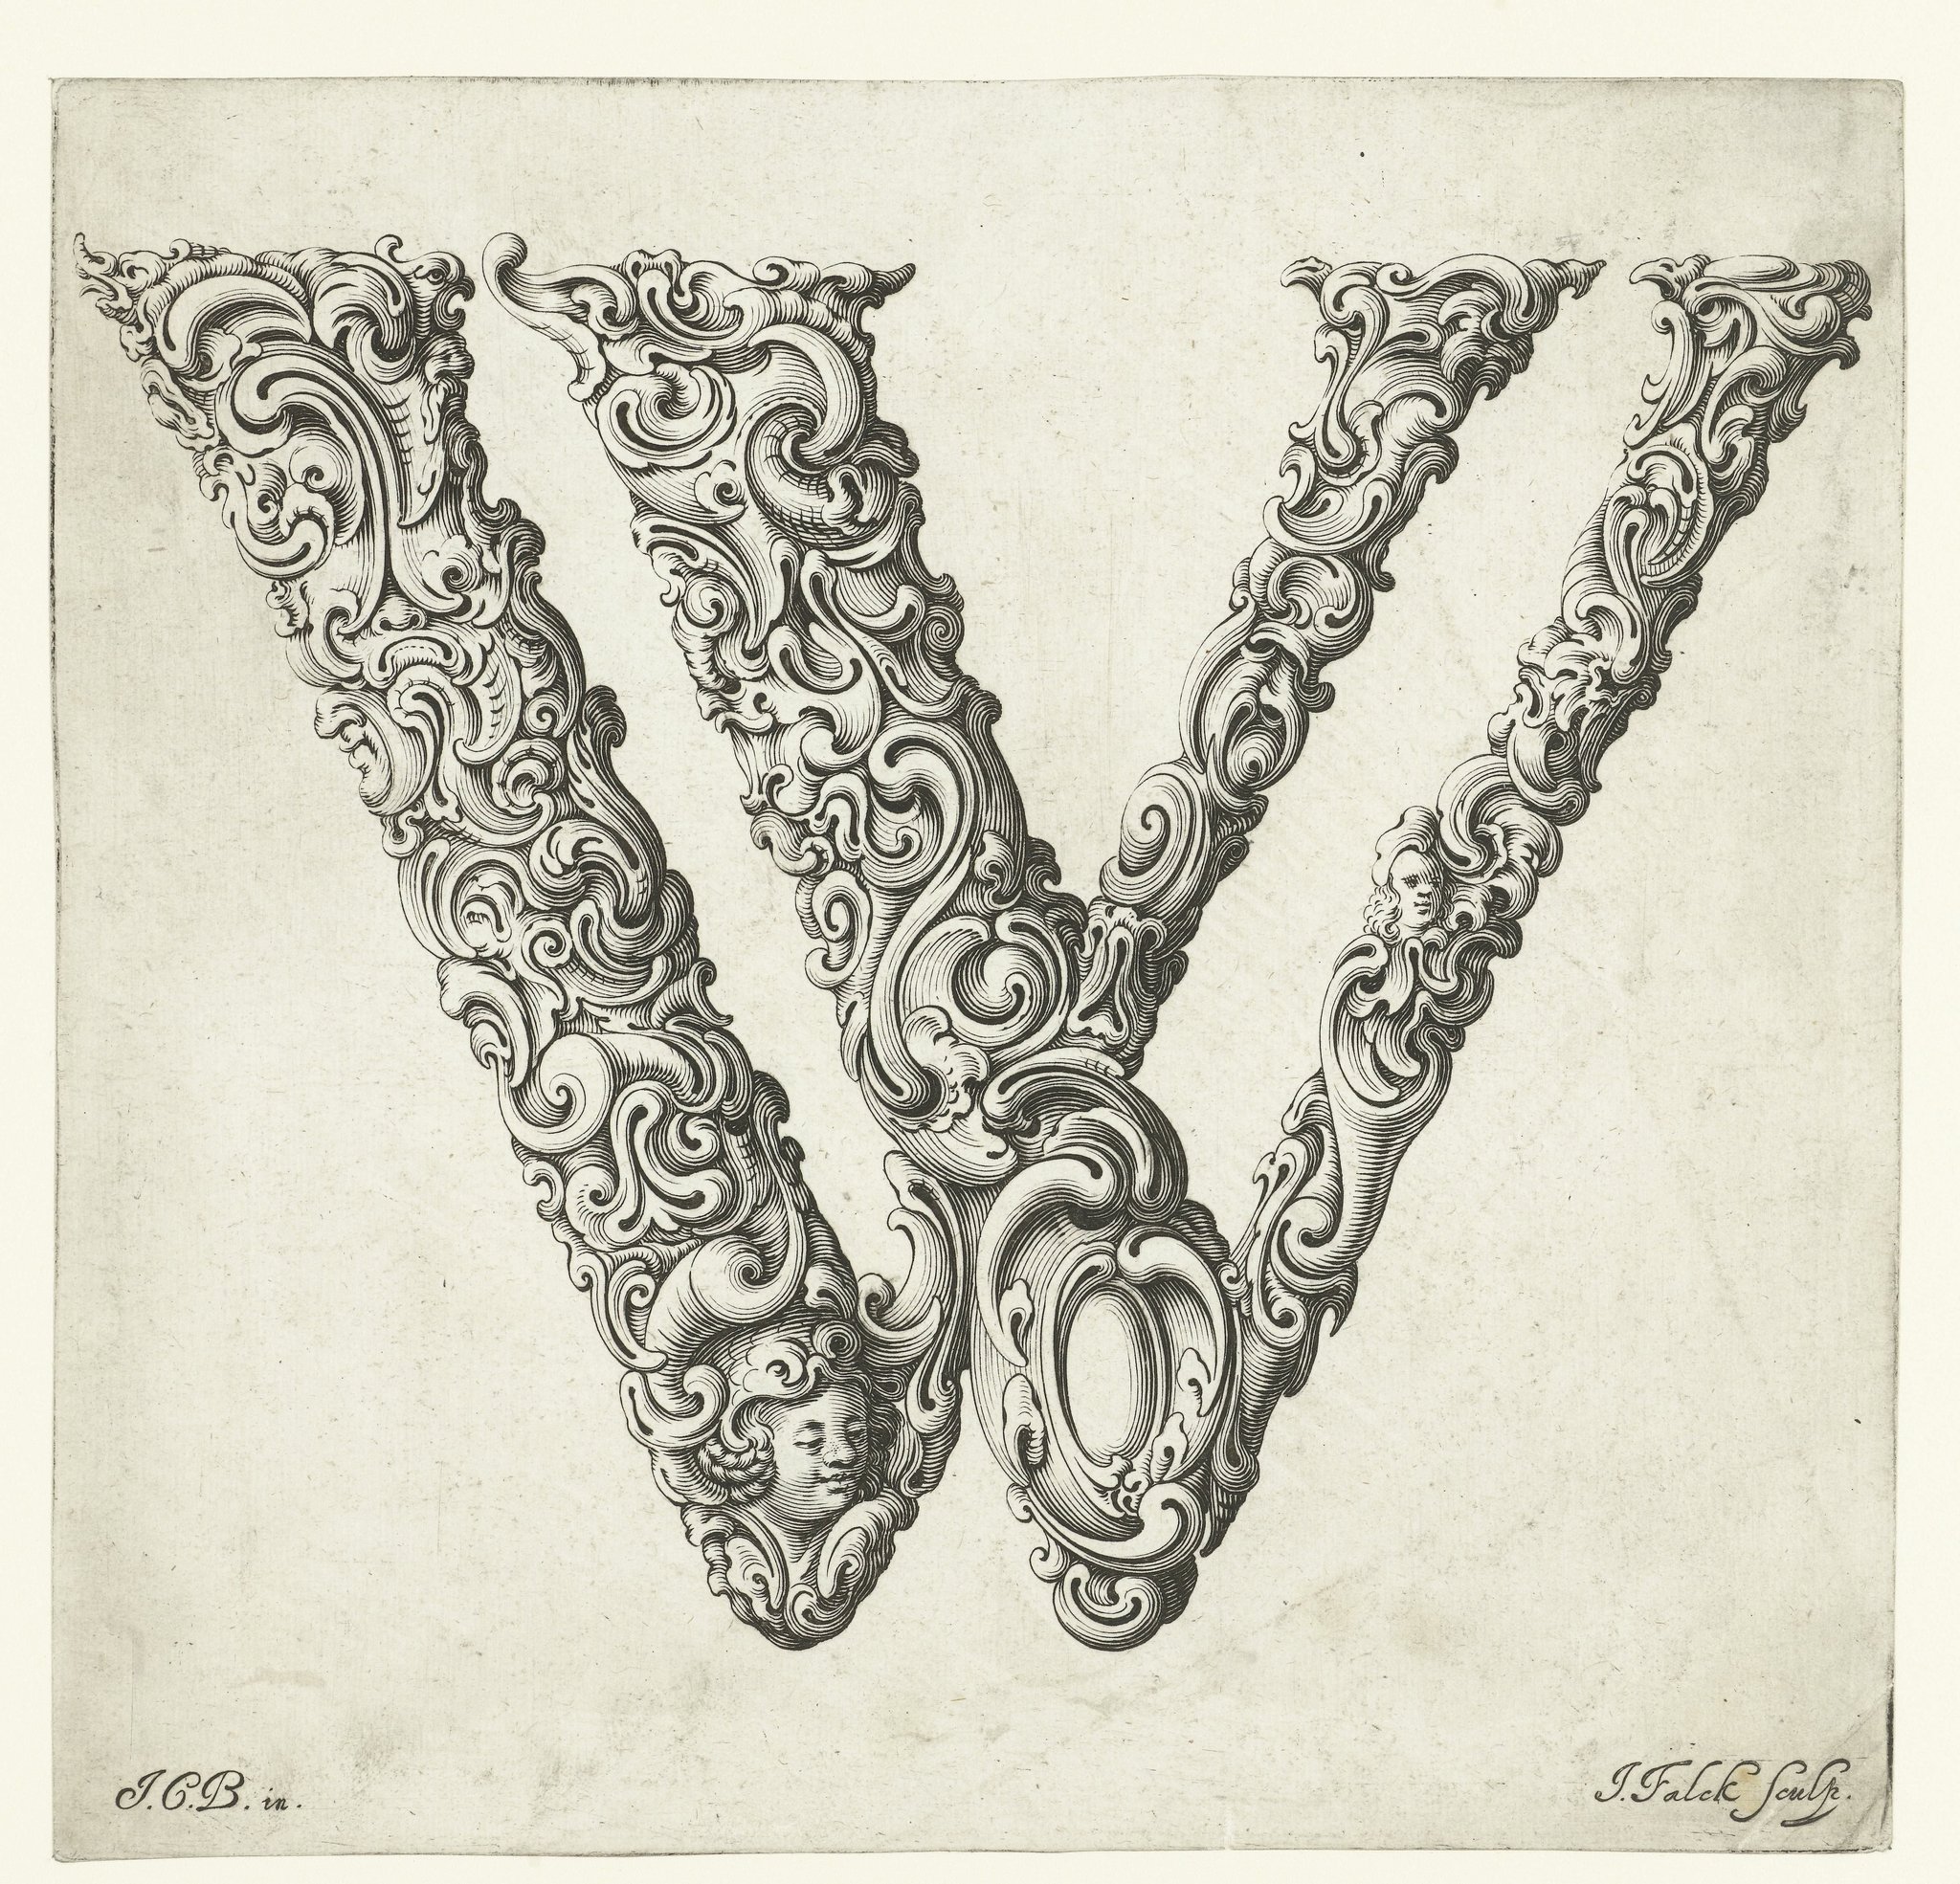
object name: print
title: Letter W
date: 1645-1650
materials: paper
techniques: engraving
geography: germany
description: Blad met de letter W uit serie van 26 bladen met letters uit het alfabet.